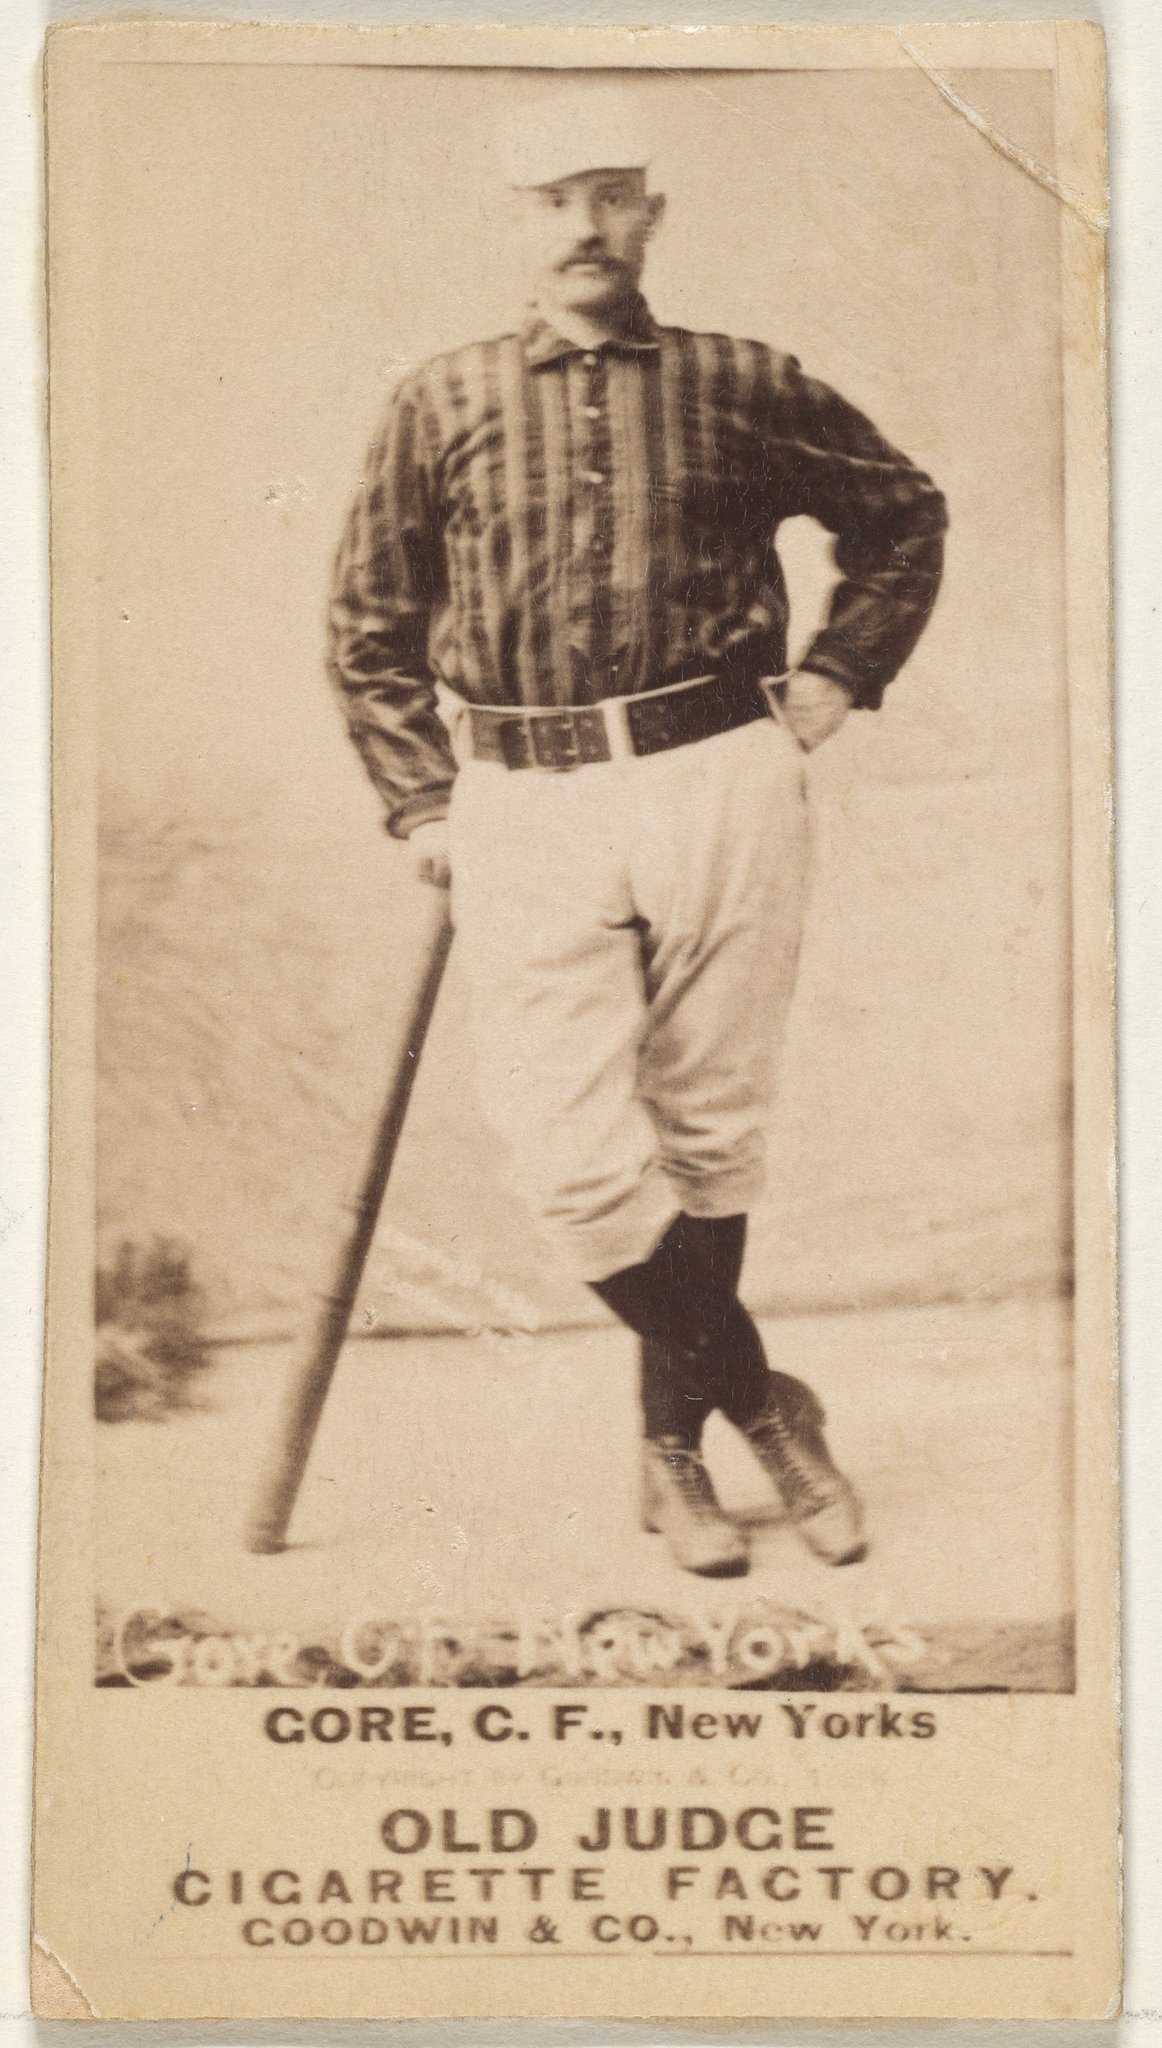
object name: baseball card, photograph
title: George F. "Piano Legs" Gore, Center Field, New York, from the Old Judge series (N172) for Old Judge Cigarettes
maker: goodwin & company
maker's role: publisher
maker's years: 1850-1950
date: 1887-1890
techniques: albumen silver print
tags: men,portraits,baseball,athletes